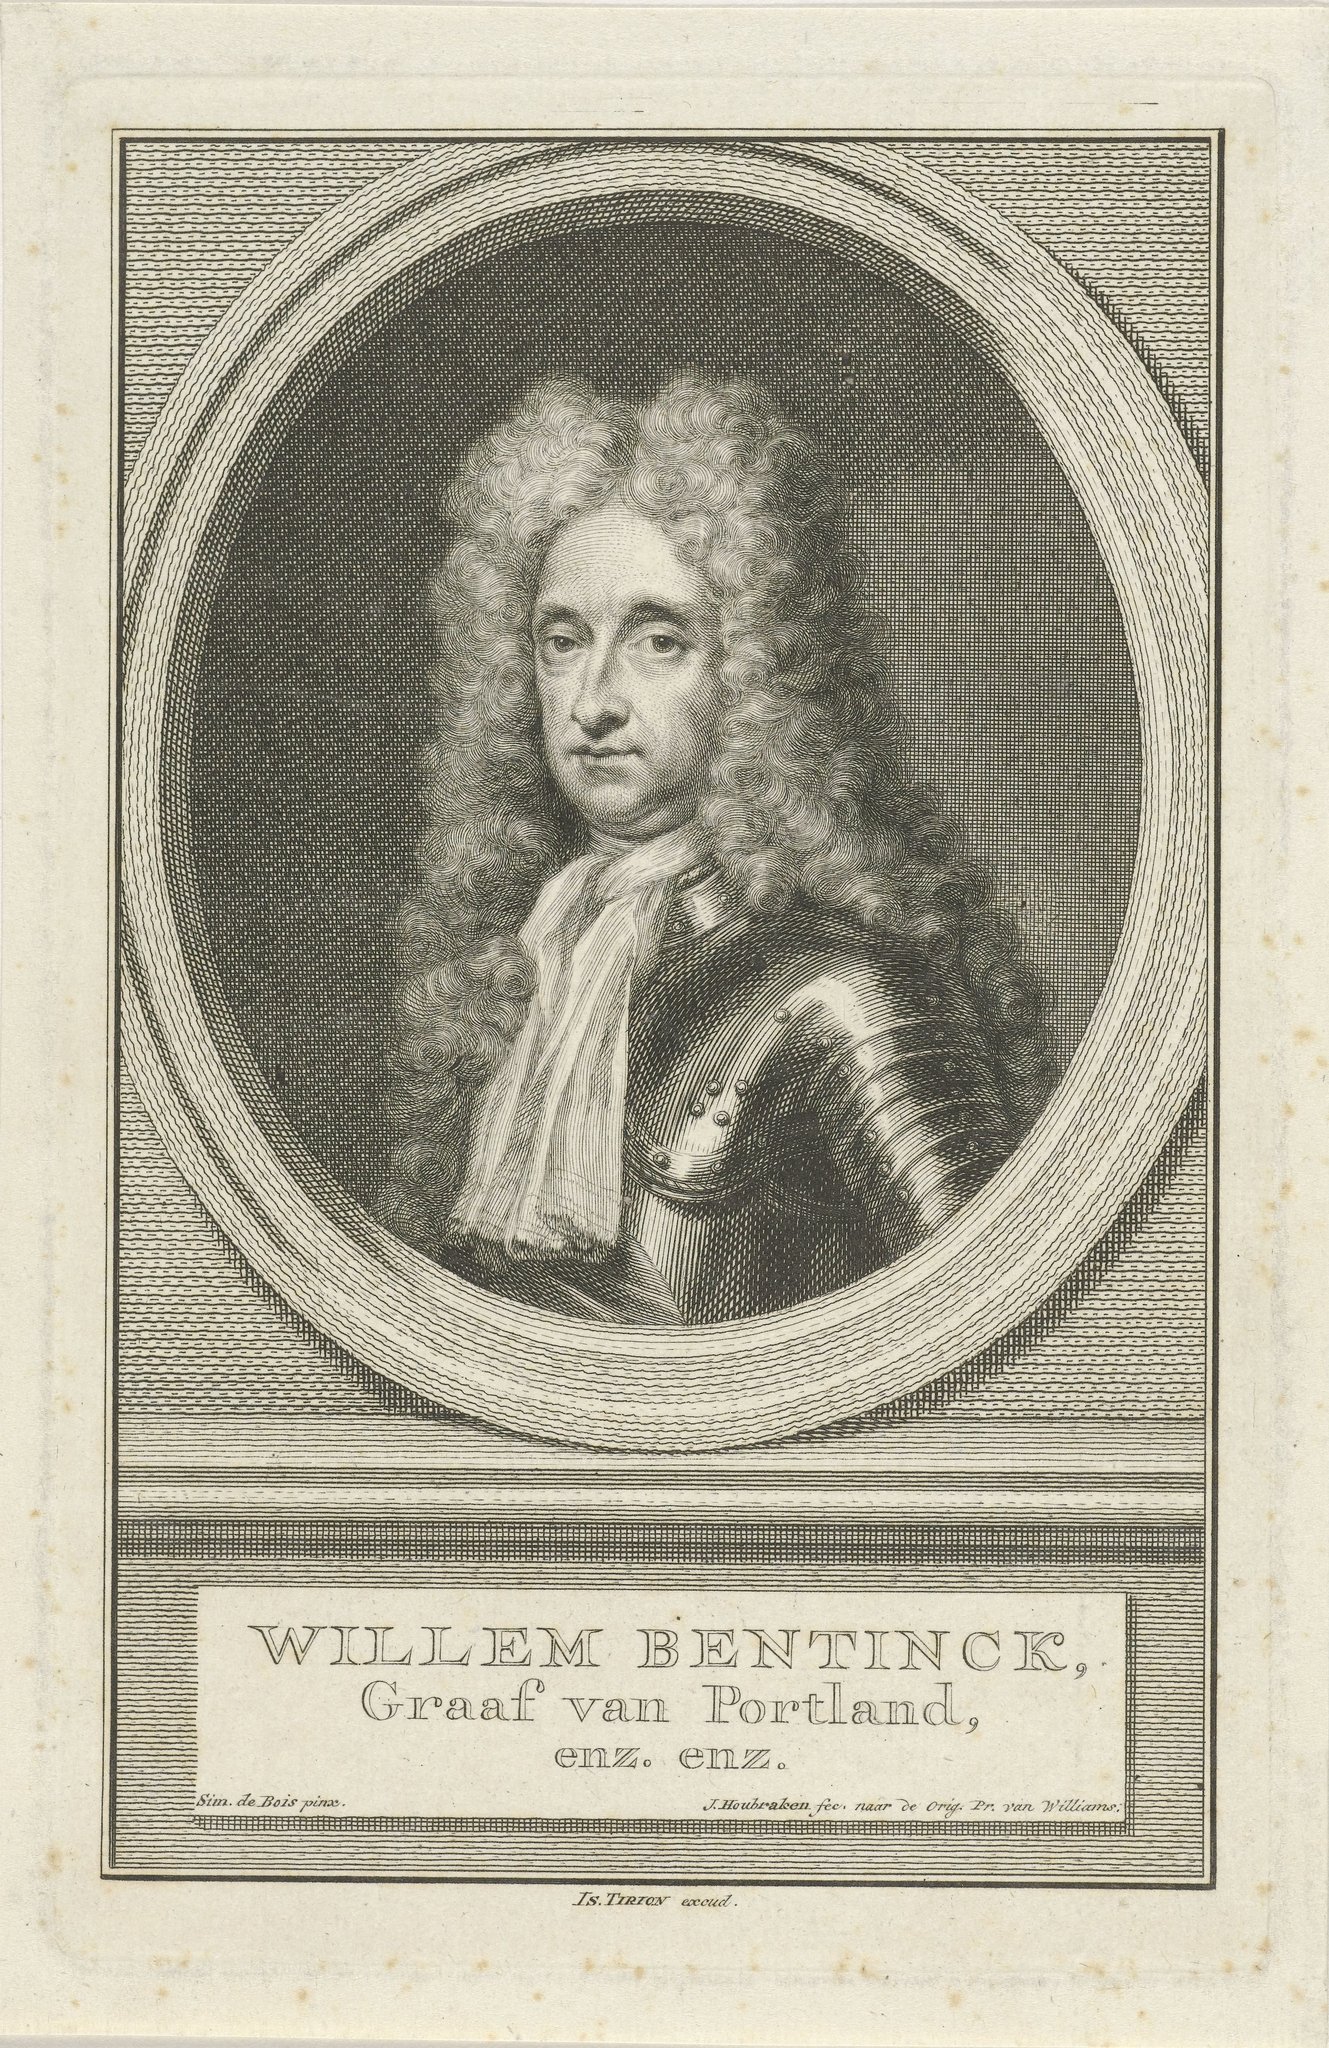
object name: print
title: Willem Bentinck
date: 1749-1759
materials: paper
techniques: engraving, etching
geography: amsterdam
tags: earl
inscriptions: collector's mark: Lugt 2228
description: Prent ook gebruikt in: Jan Wagenaar, Vaderlandsche historie, vervattende de geschiedenissen der nu Vereenigde Nederlanden, inzonderheid die van Holland (...), 21 delen. Amsterdam, Isaak Tirion, 1749-59.